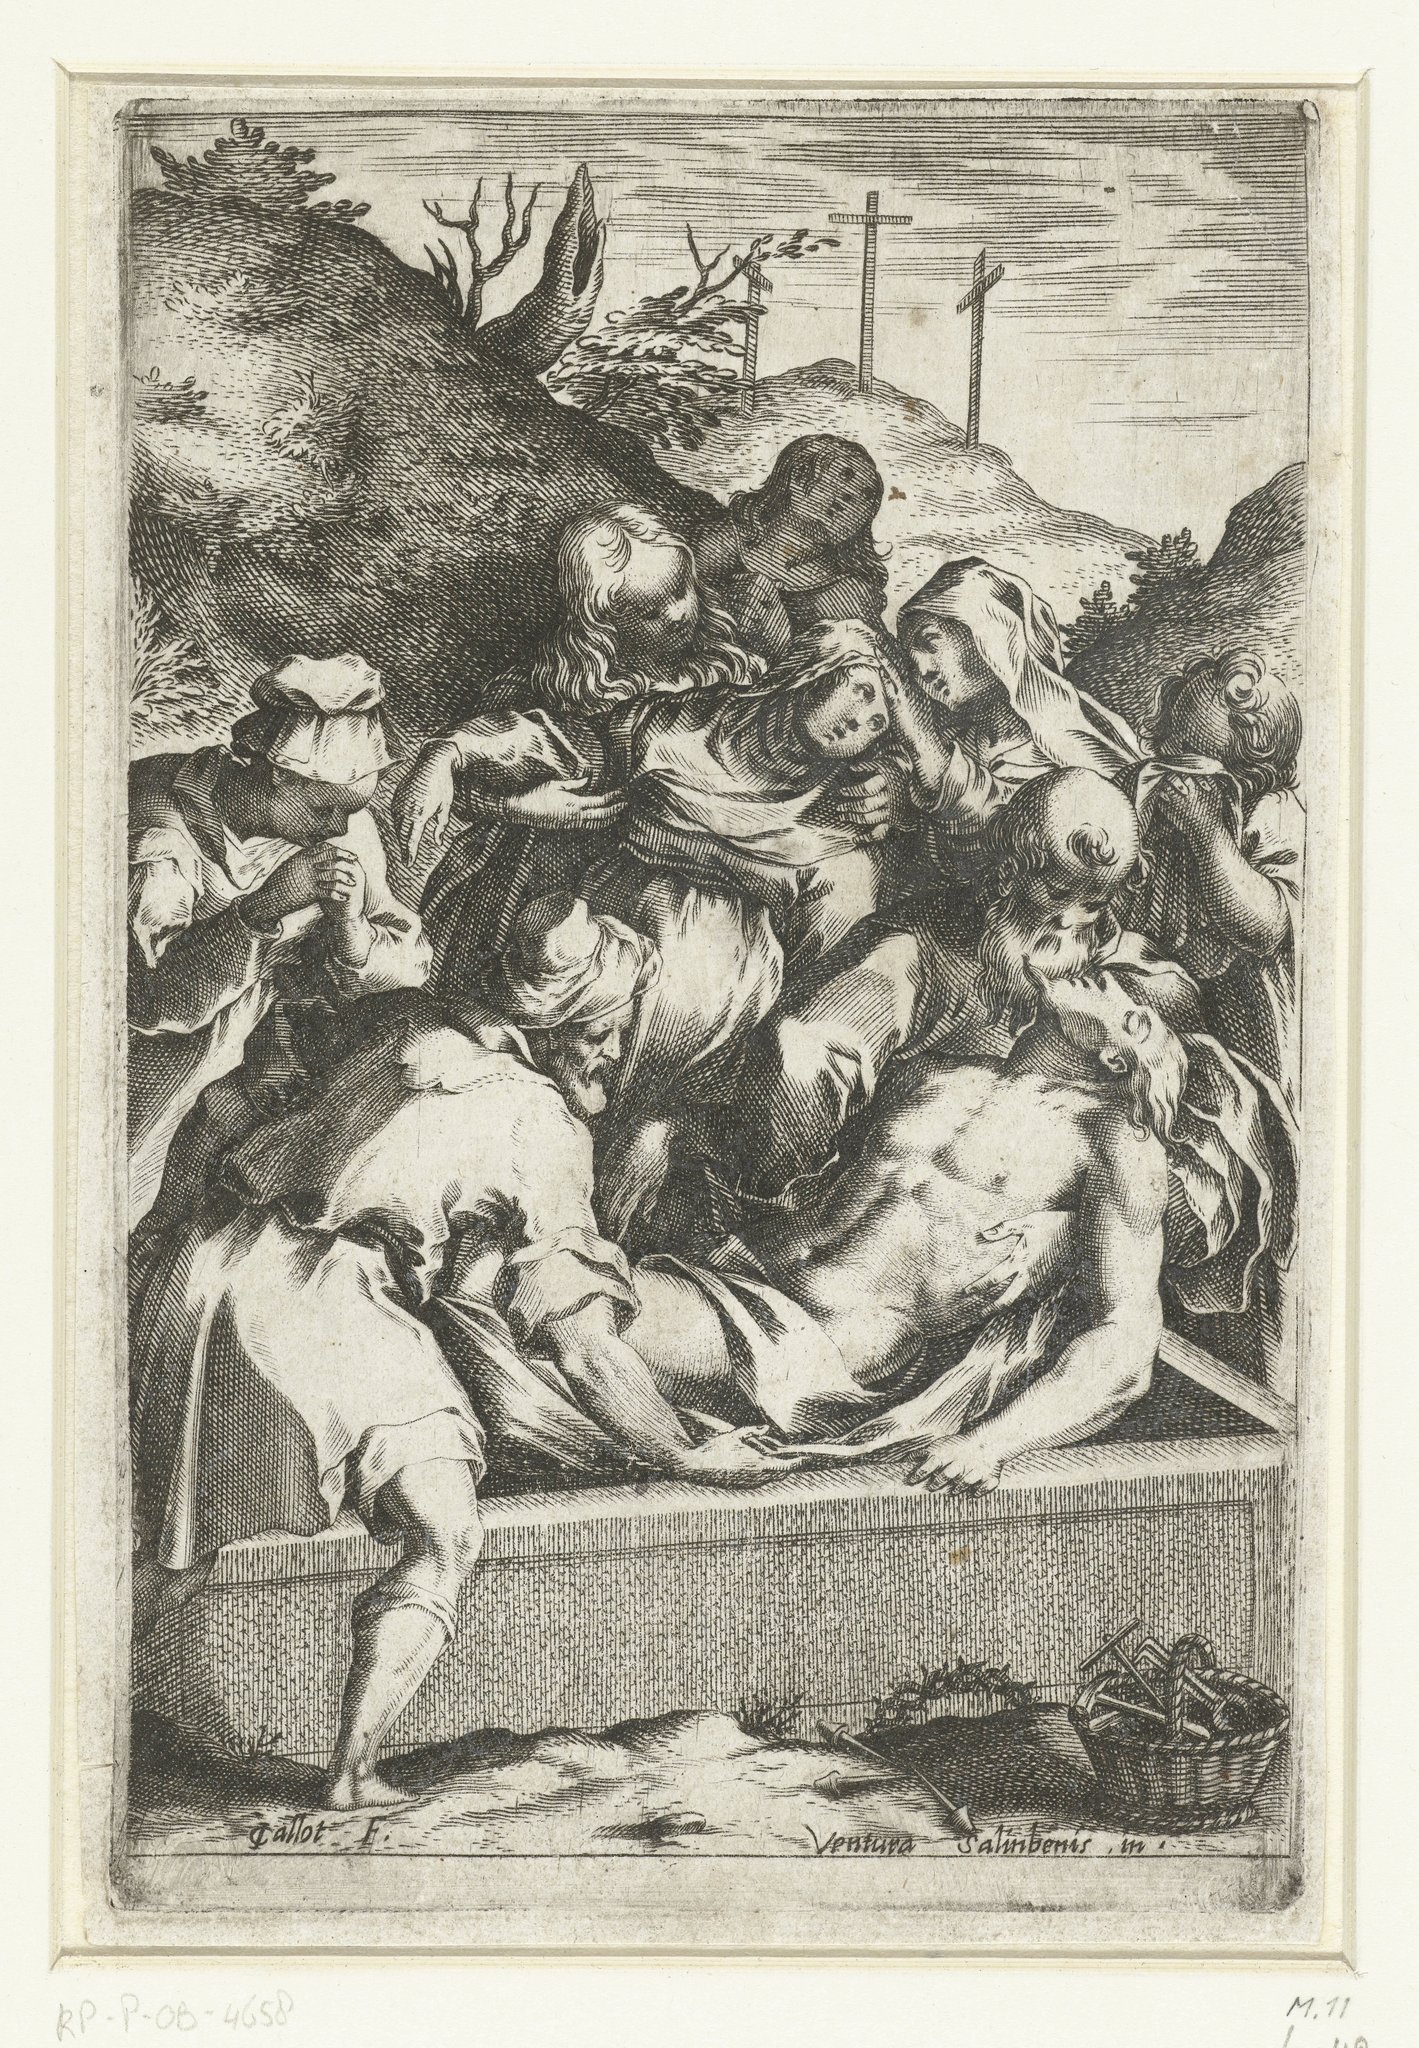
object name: print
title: Graflegging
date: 1609-1611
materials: paper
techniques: engraving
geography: rome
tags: christ's entombment (possibly by angels)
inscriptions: collector's mark: Lugt 240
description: Christus wordt door twee mannen in een graf gelegd. Een aantal vrouwen staat erbij, onder wie Maria.